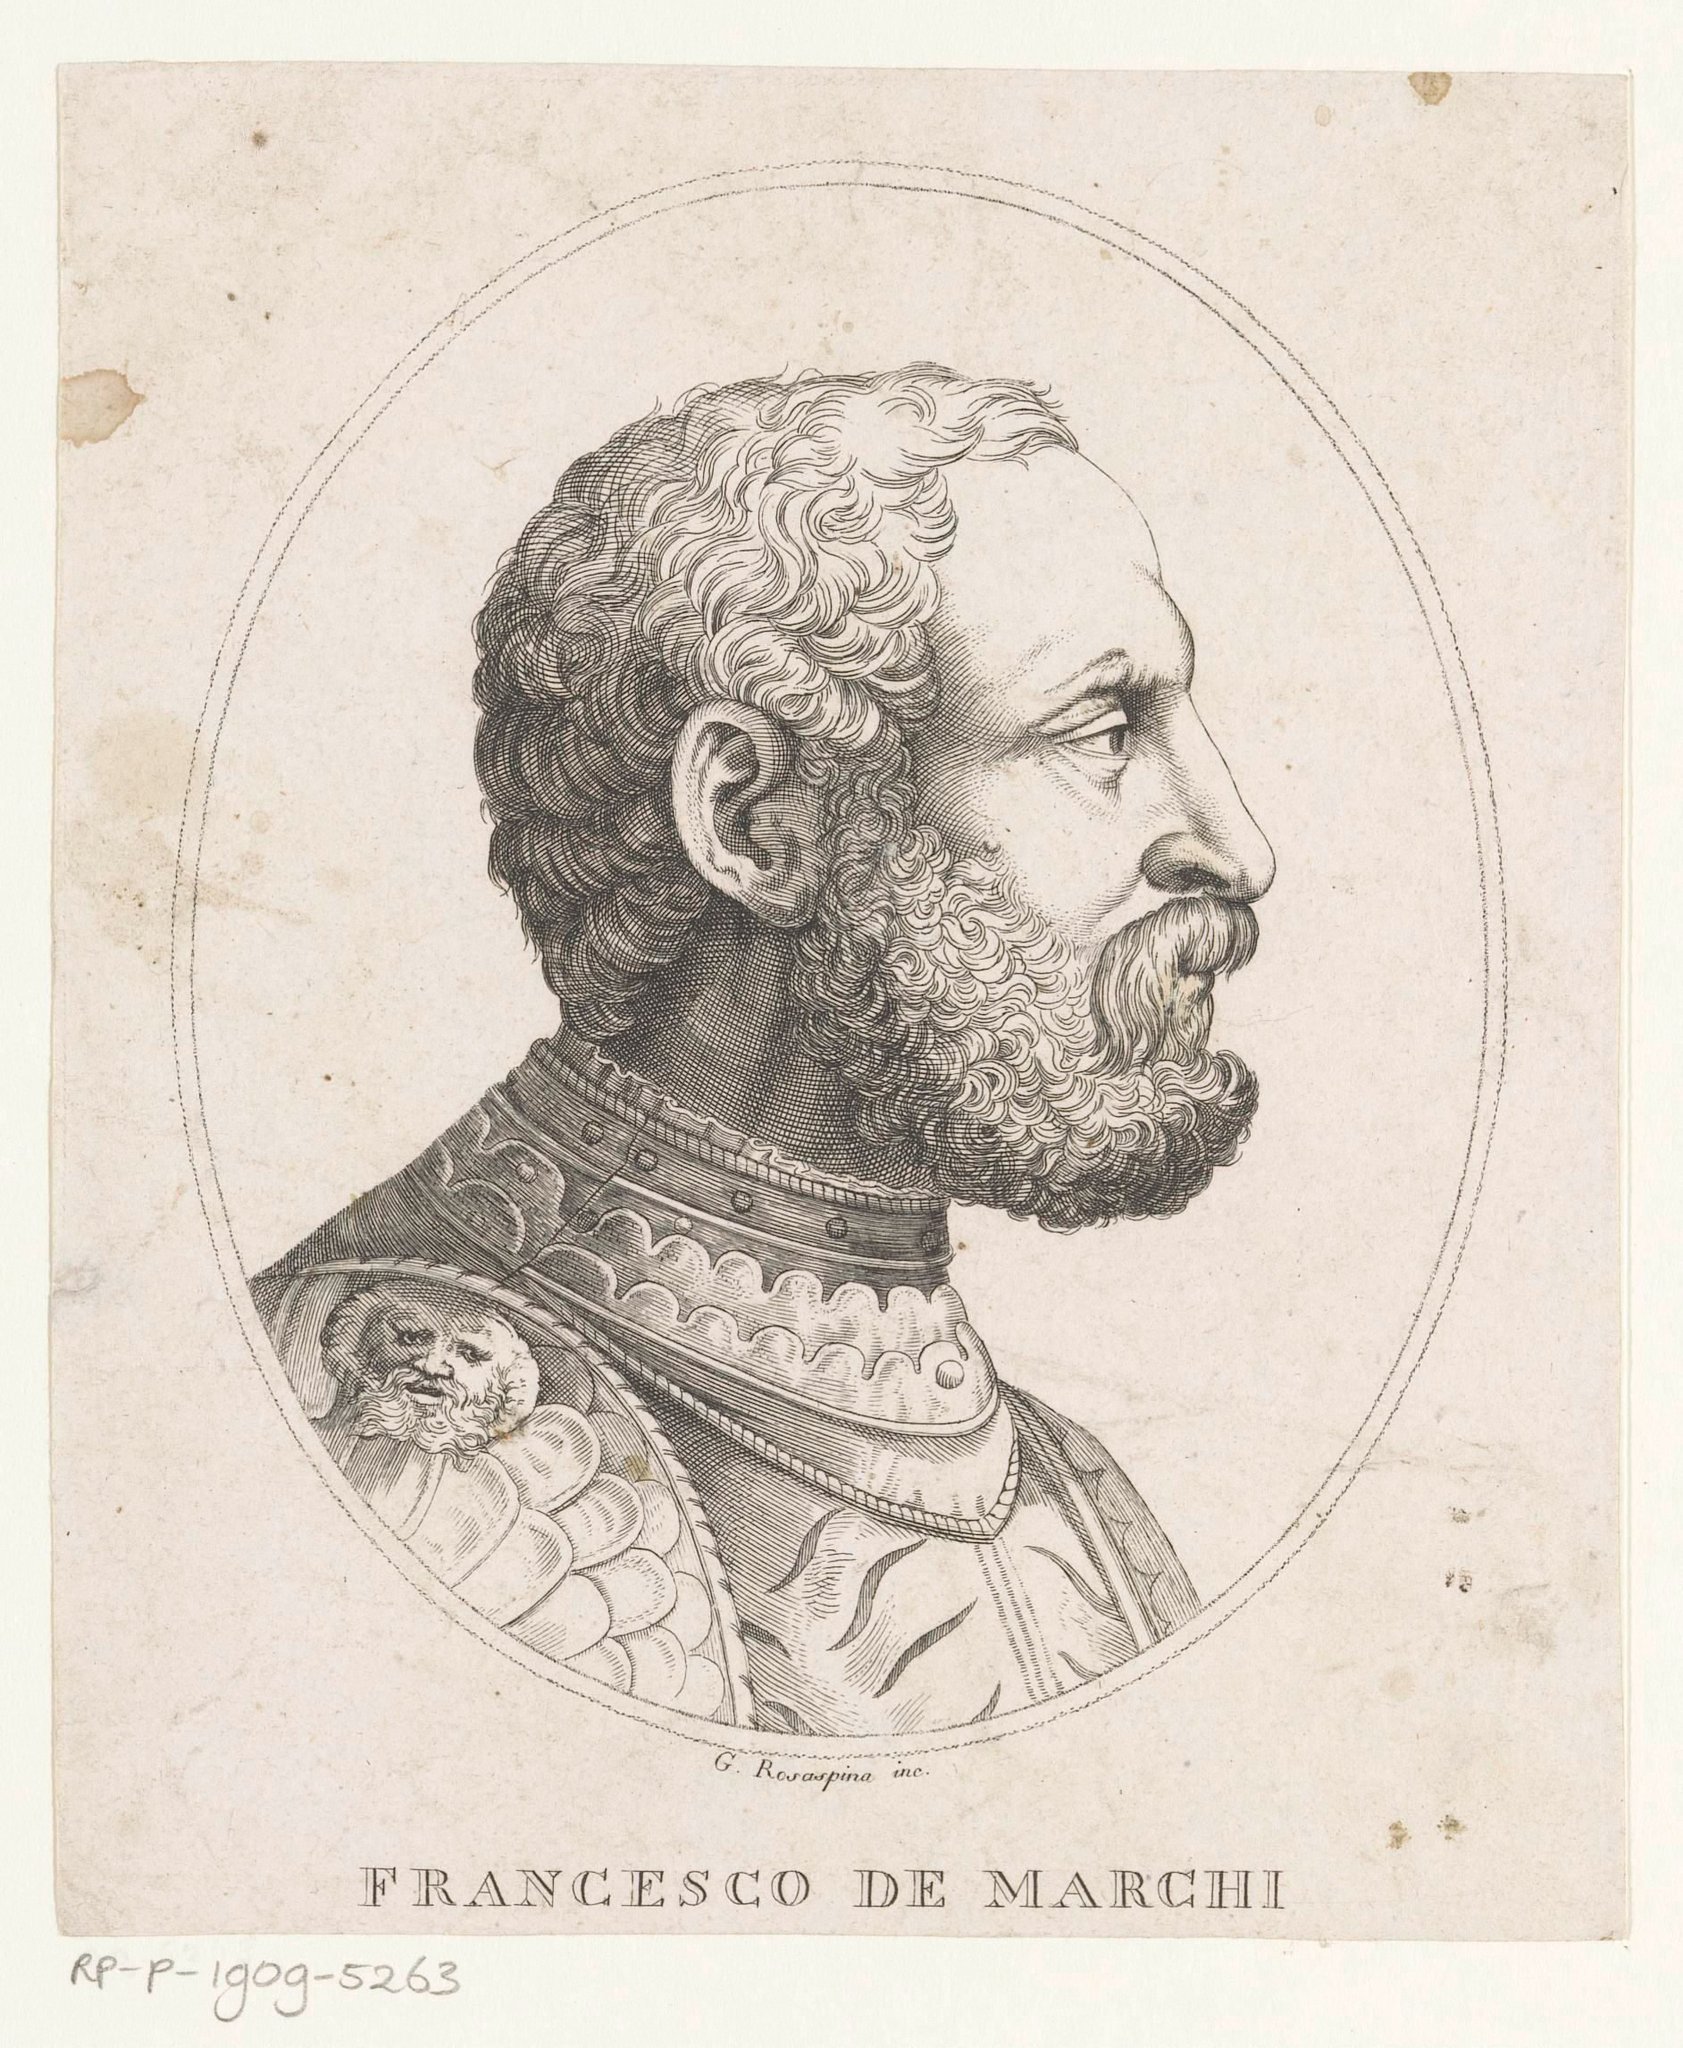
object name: print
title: Portret van Francesco De Marchi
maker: giuseppe rosaspina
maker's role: print maker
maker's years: 1765-1832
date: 1775-1832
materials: paper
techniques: engraving, etching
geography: italy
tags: engineer, historical persons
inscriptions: collector's mark: Lugt 2228